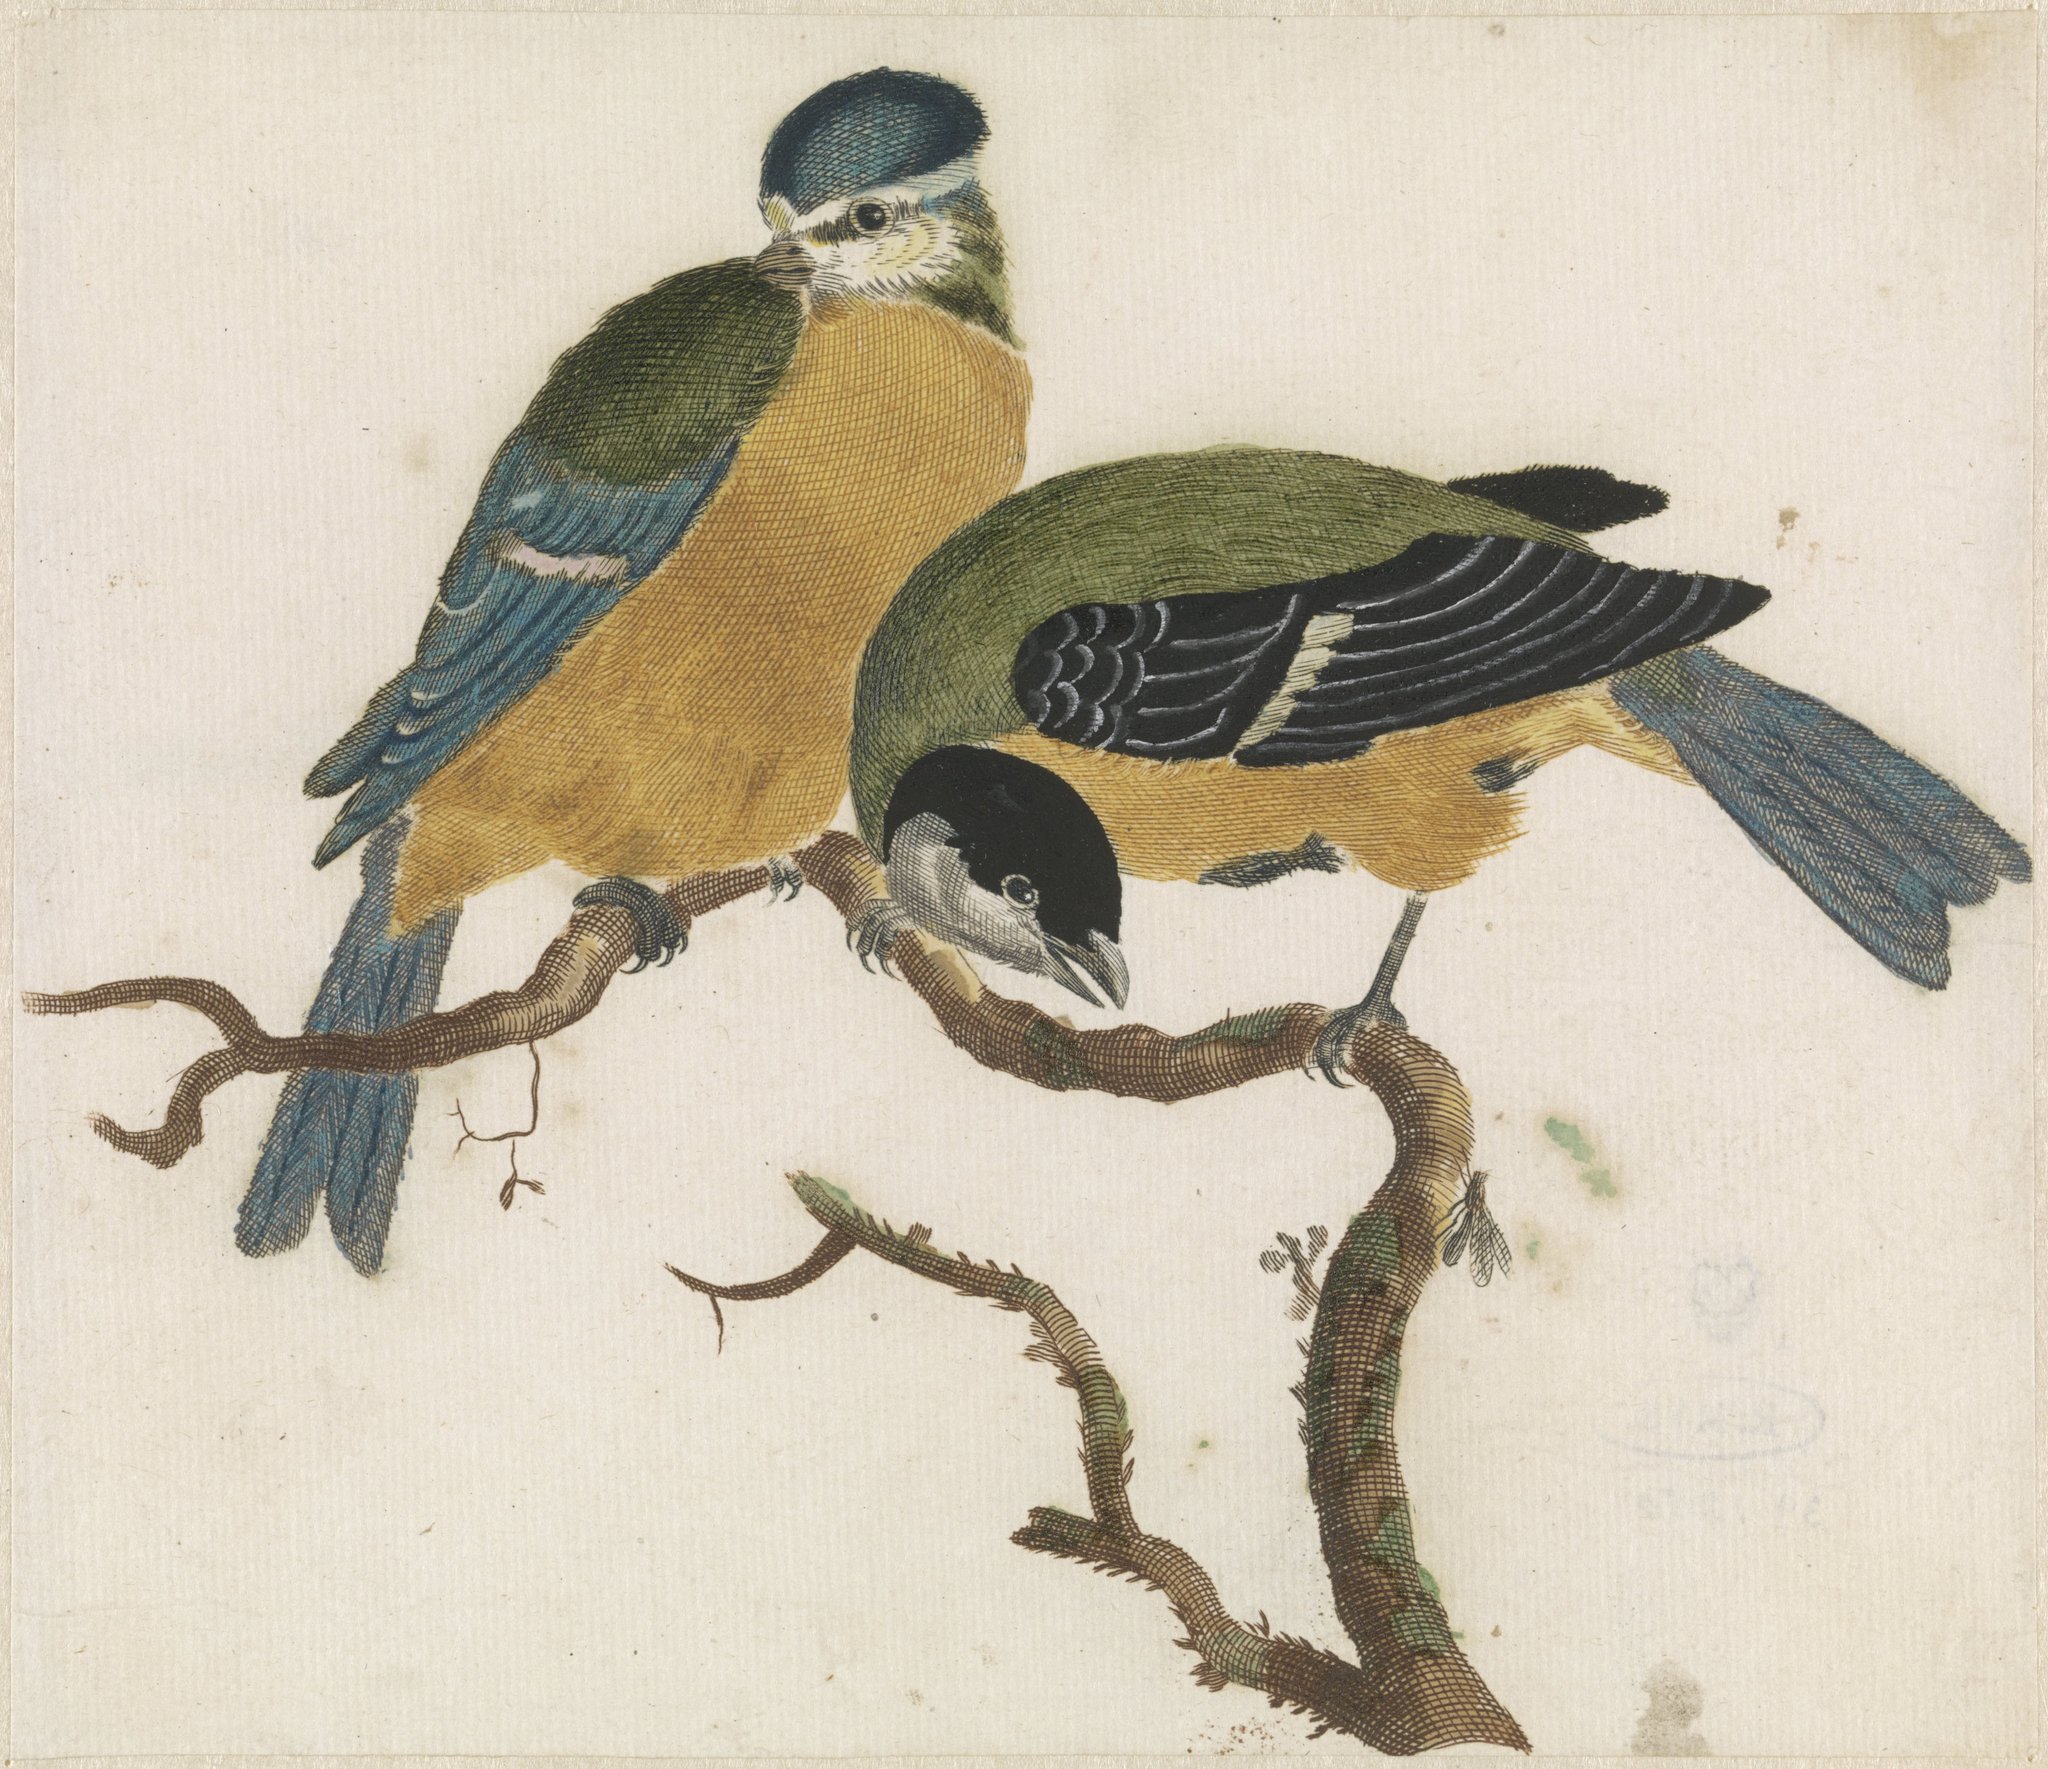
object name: print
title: Een Pimpelmees en een Koolmees op een tak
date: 1688-1698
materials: paper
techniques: printing, engraving, hand coloring, lithography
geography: netherlands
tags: song-birds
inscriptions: collector's mark: Lugt 2760, collector's mark: Lugt 2228